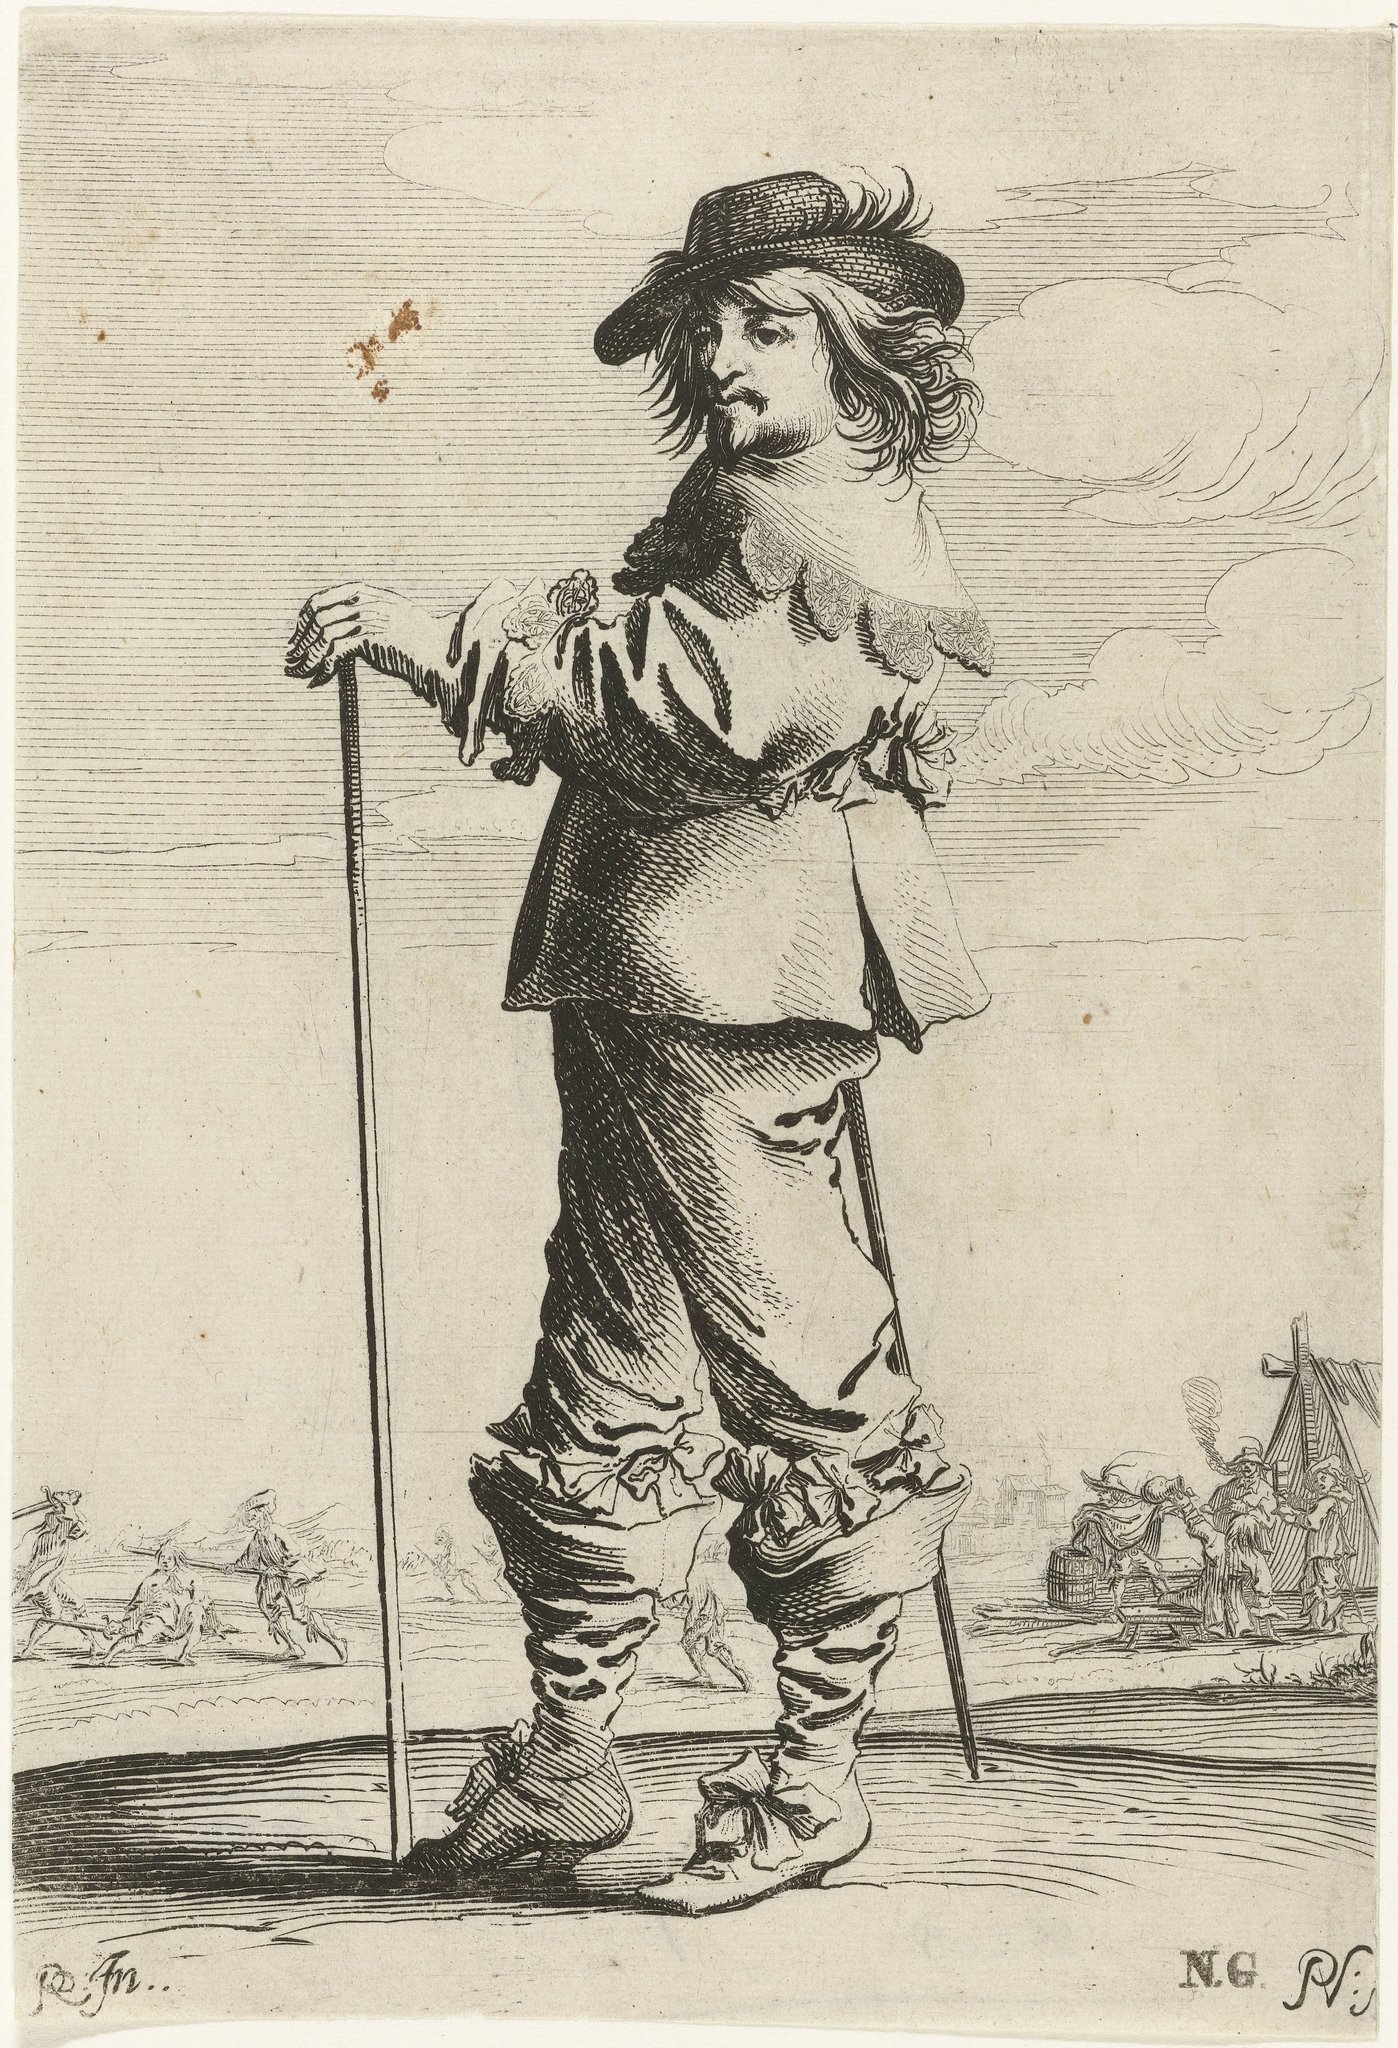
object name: costume print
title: Staande man met stok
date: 1623-1653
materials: paper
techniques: engraving, etching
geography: amsterdam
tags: head-gear: hat (+ men's clothes), clothes, costume (+ men's clothes), neck-gear: collar (+ men's clothes), trousers, breeches, etc. (breeches) (+ men's clothes), clothing for the upper part of the body (doublet) (+ men's clothes), boots (+ men's clothes), walking-stick, staff, cane (+ men's clothes), netherlands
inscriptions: collector's mark: Lugt 1967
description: Man met stok, gekleed volgens de Nederlandse mode van ca. 1625- 1635, staand in landschap, naar links. Kampement en vechtende mannen op de achtergrond. Prent is deel van een serie van verschillende dames en herenkostuums.